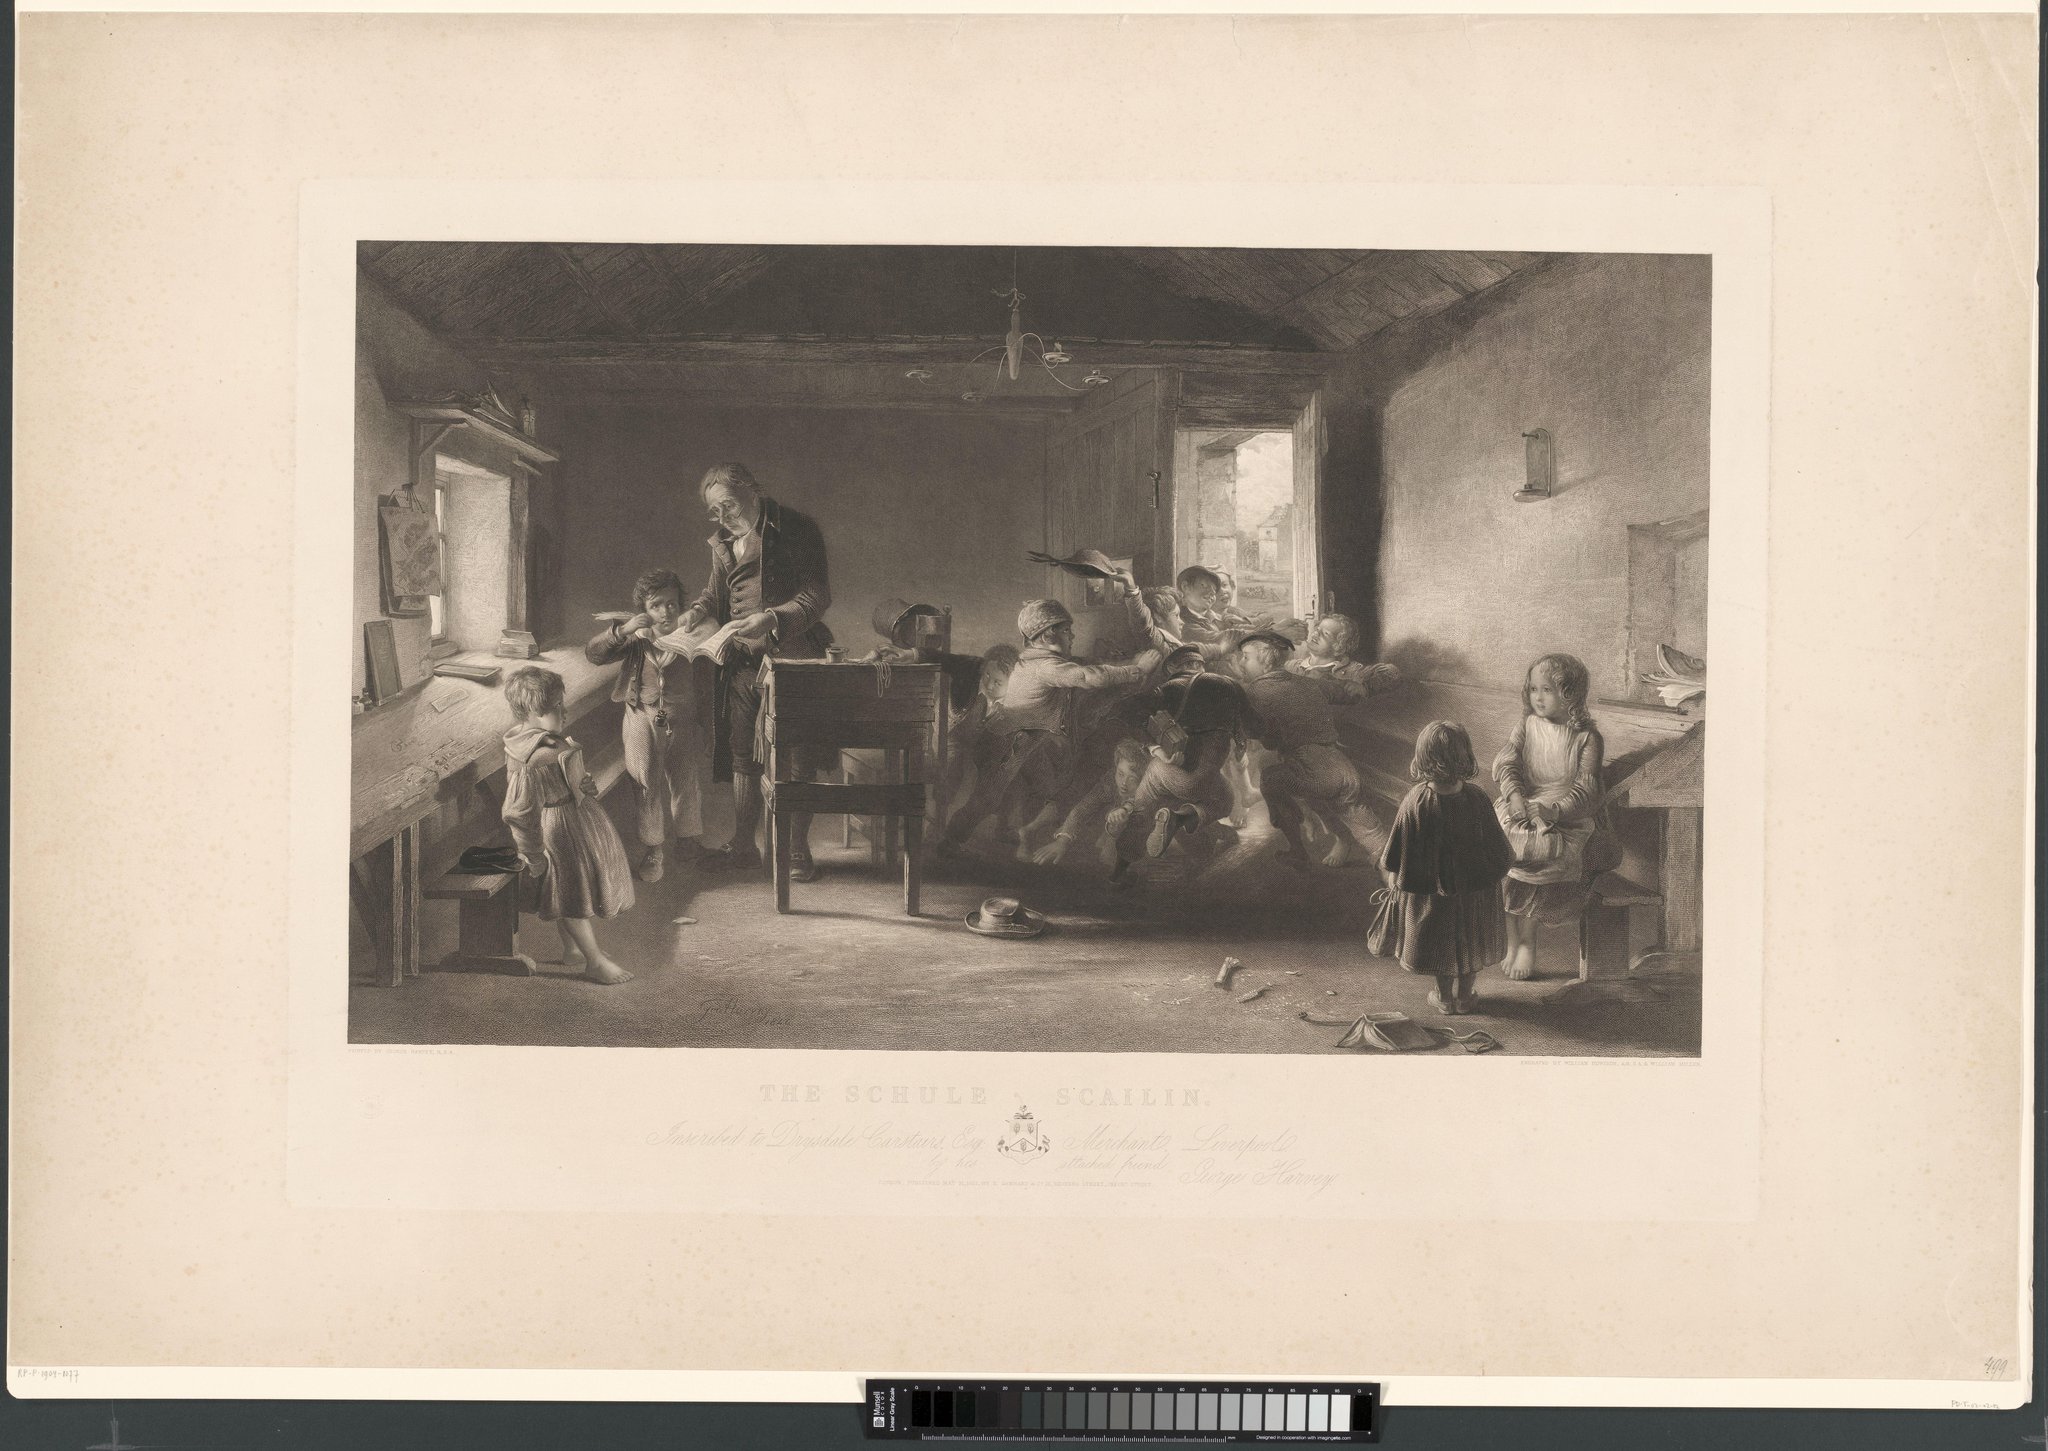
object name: print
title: Schoolklas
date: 1851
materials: paper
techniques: engraving, etching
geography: london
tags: teacher and pupil, elementary school; class, form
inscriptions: check stamp: Lugt 4736, collector's mark: Lugt 2228